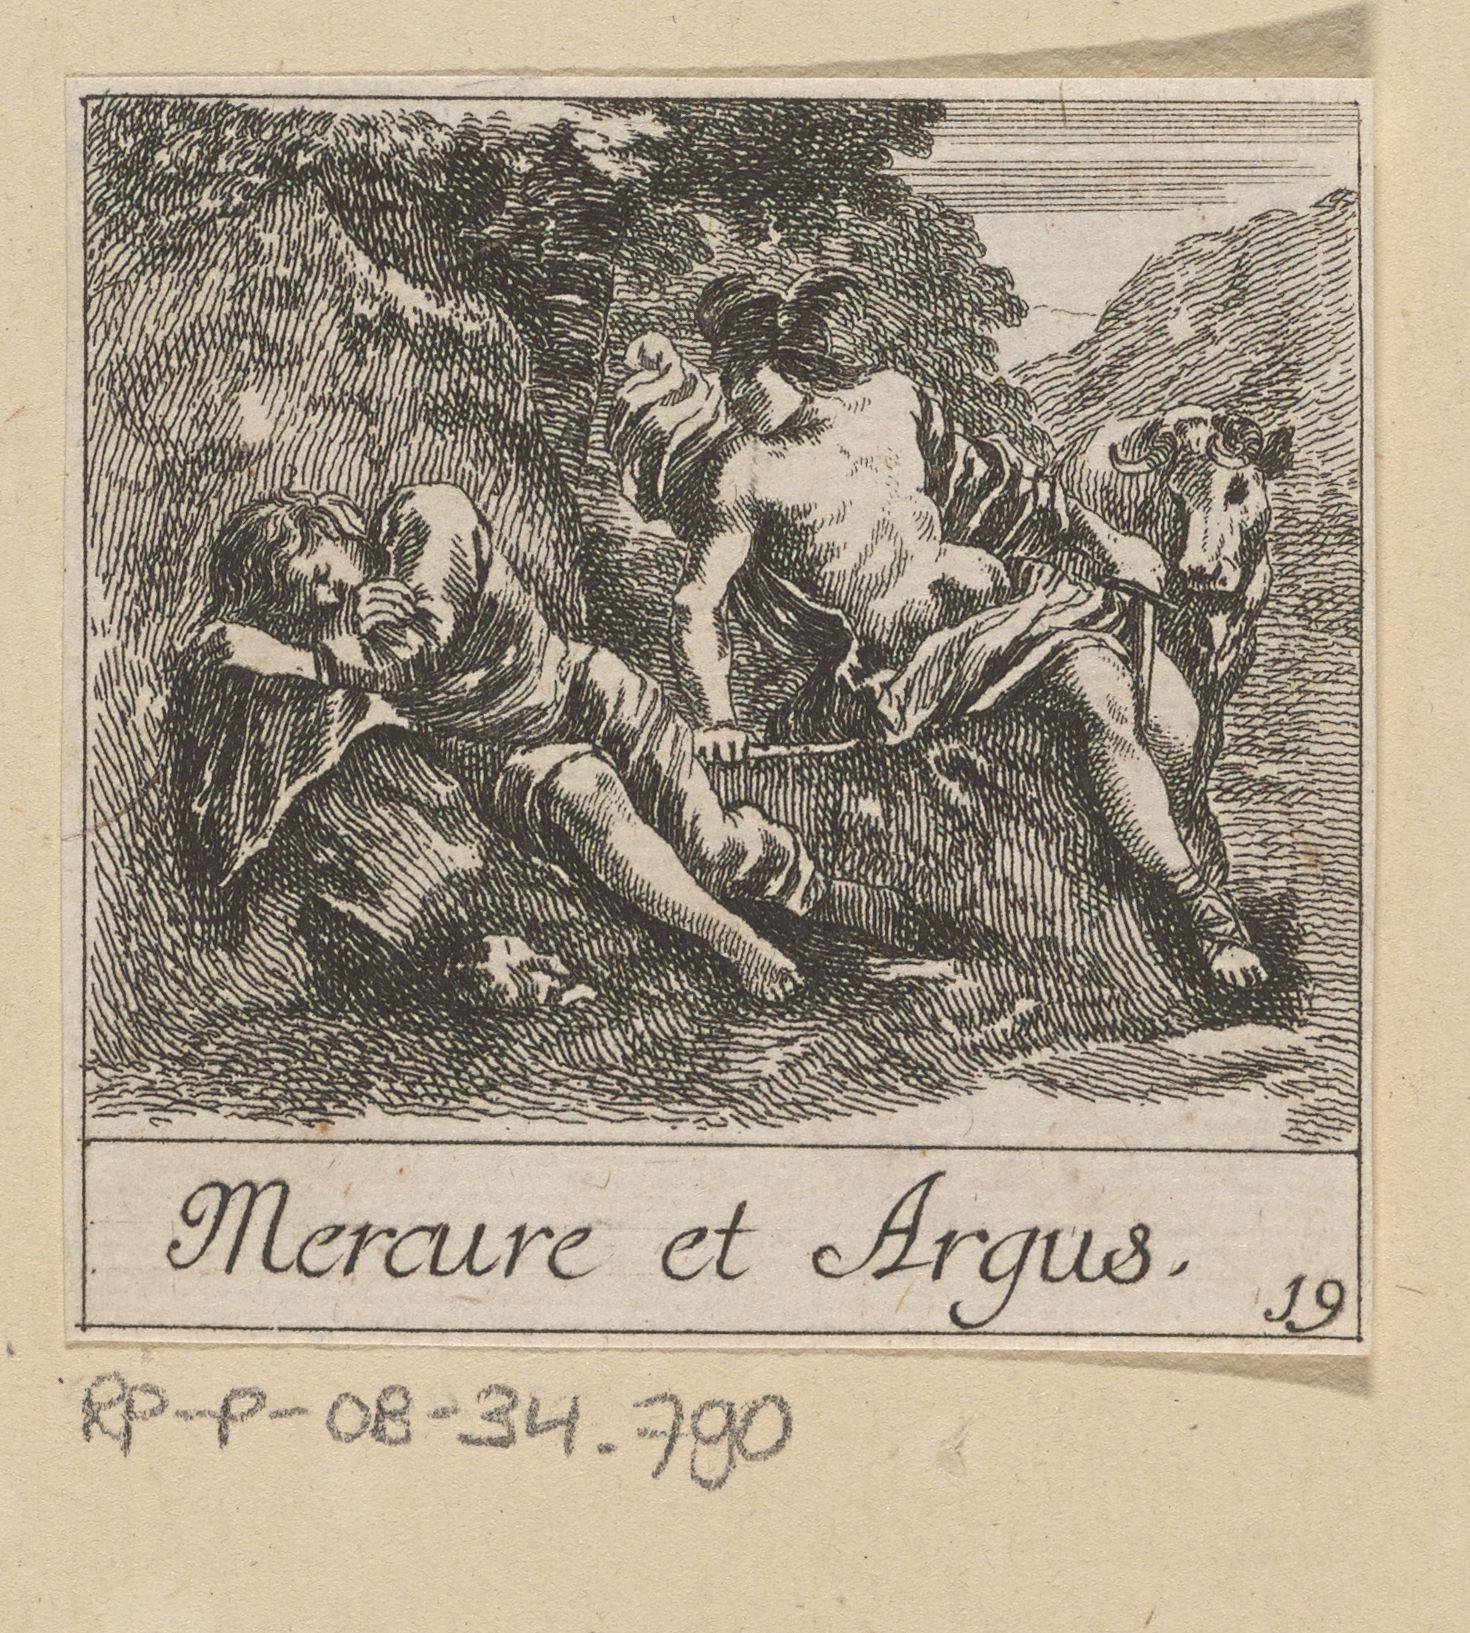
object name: print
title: Mercurius en Argus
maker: Anonymous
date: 1620-1664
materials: paper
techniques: etching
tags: (story of) mercury (hermes)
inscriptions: collector's mark: Lugt 240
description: Prent uit een reeks van 54 genummerde speelkaarten met voorstellingen uit de Metamorfosen van Ovidius.